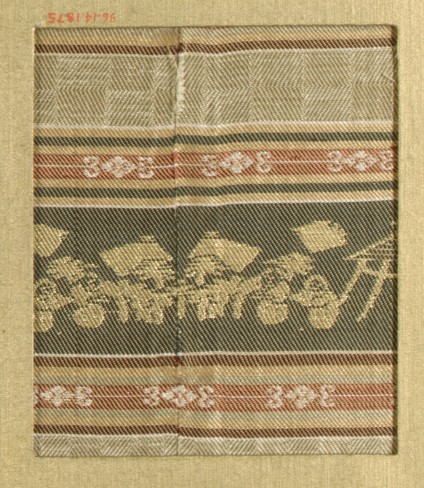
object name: piece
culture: japanese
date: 1701-1900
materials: silk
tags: human figures